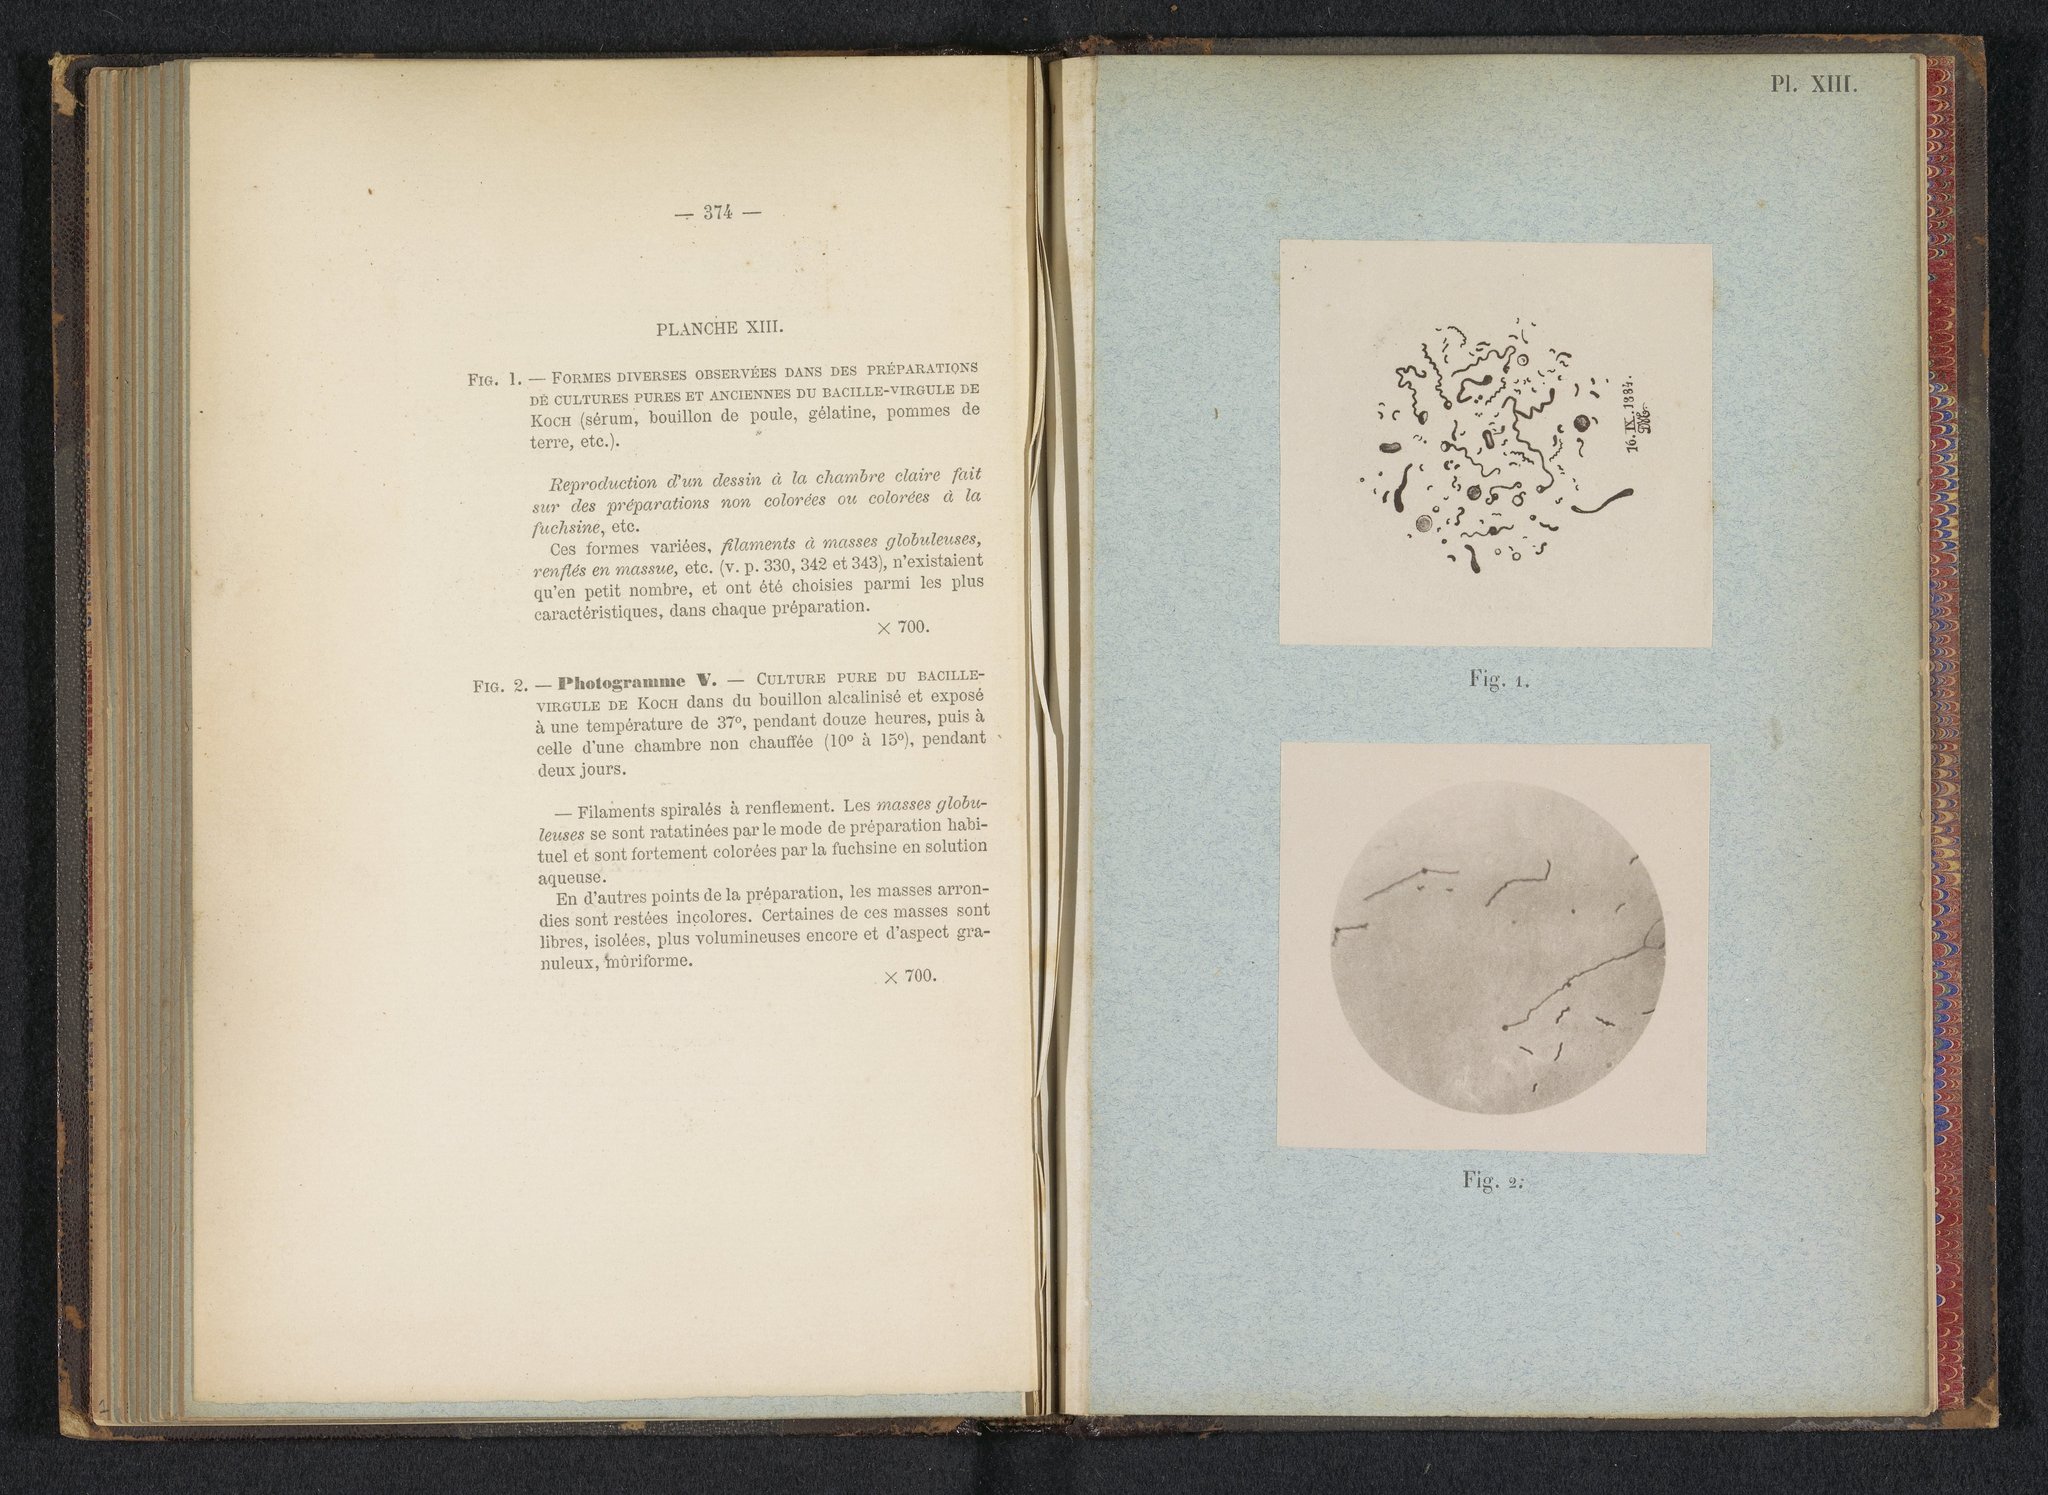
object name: page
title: Microscoopopname van cholera en een fotoreproductie van een tekening daarvan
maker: émile van ermengem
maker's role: bioloog, fotograaf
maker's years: 1851-1932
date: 1875-1885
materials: paper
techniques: photograph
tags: diseases affecting the whole body, microscope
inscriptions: inscription: ‘Fig. 1.- Formes diverses observées dans des préparations de cultures pures et anciennes du bacille-virgule de Koch (...) Fig. 2. - Photogramme V.-Culture pure du bacille-virgule de Koch (...)’, number: ‘Pl. XIII. Fig. 1. Fig. 2.’